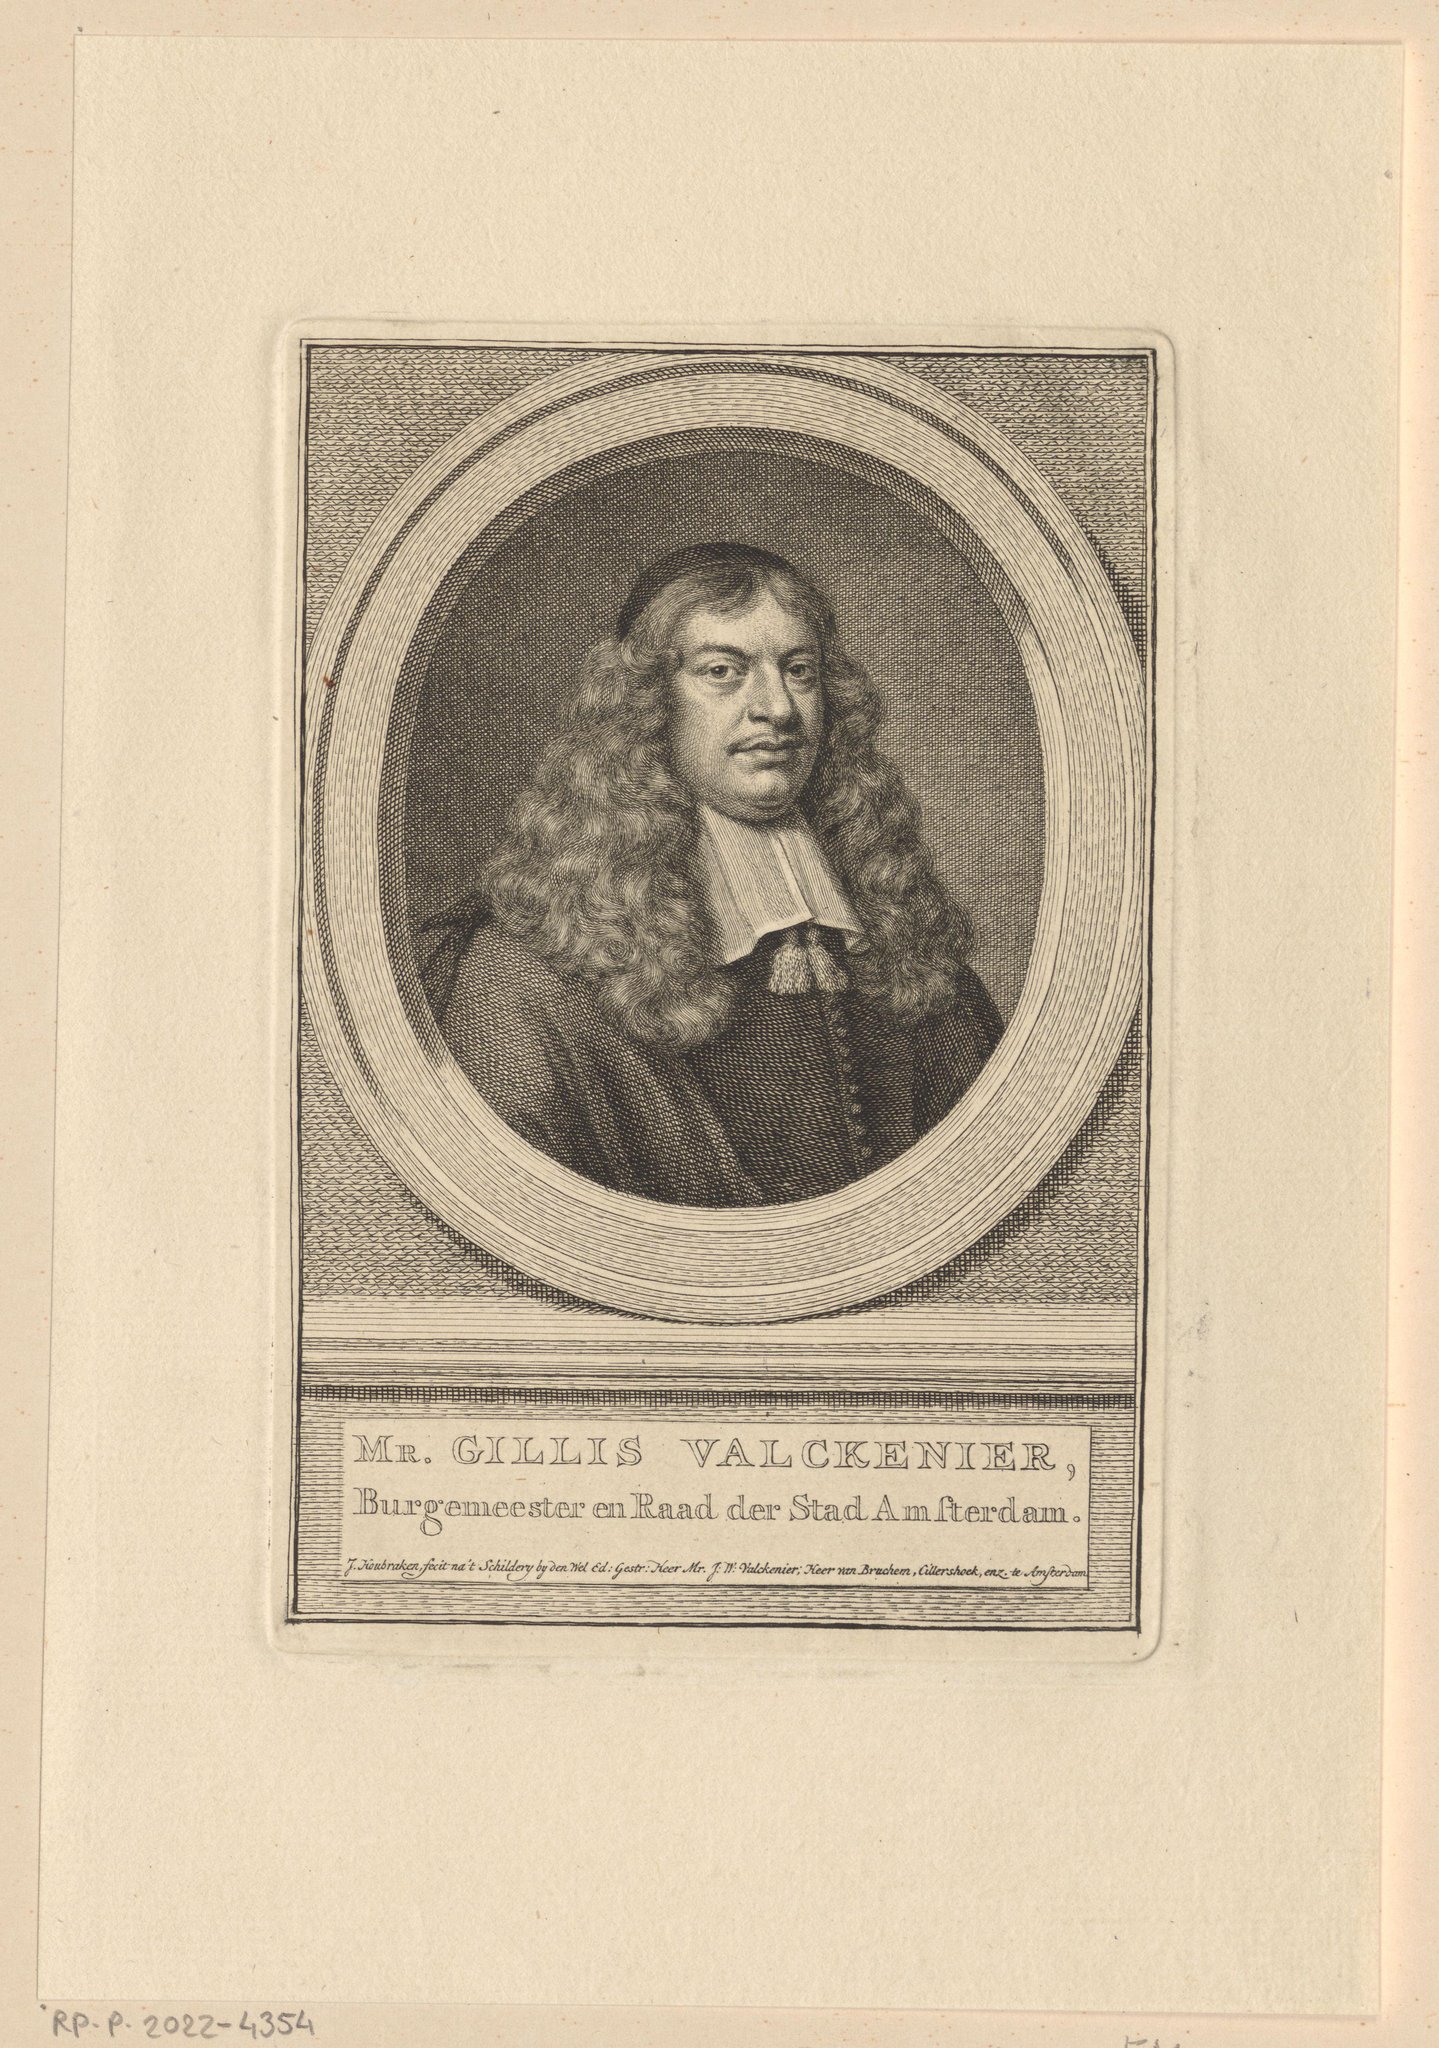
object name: print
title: Portret van Gillis Valckenier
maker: jacob houbraken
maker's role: draughtsman, print maker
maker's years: 1698-1780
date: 1796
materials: paper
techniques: engraving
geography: amsterdam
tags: mayor, burgomaster, historical persons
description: Prent uitgegeven als aanvulling op: Wagenaar, Jan. Vaderlandsche historie, vervattende de geschiedenissen der nu Vereenigde Nederlanden (…). Amsterdam: Johannes Allart, 1790-1796, 21 delen. Voor de advertentie waarin Allart de 60 portretten en 7 platen, allen gegraveerd door Houbraken, ter aanvulling op Wagenaars ‘Vaderlandsche historie’ aanbiedt, zie: RP-P-OB-77.766.